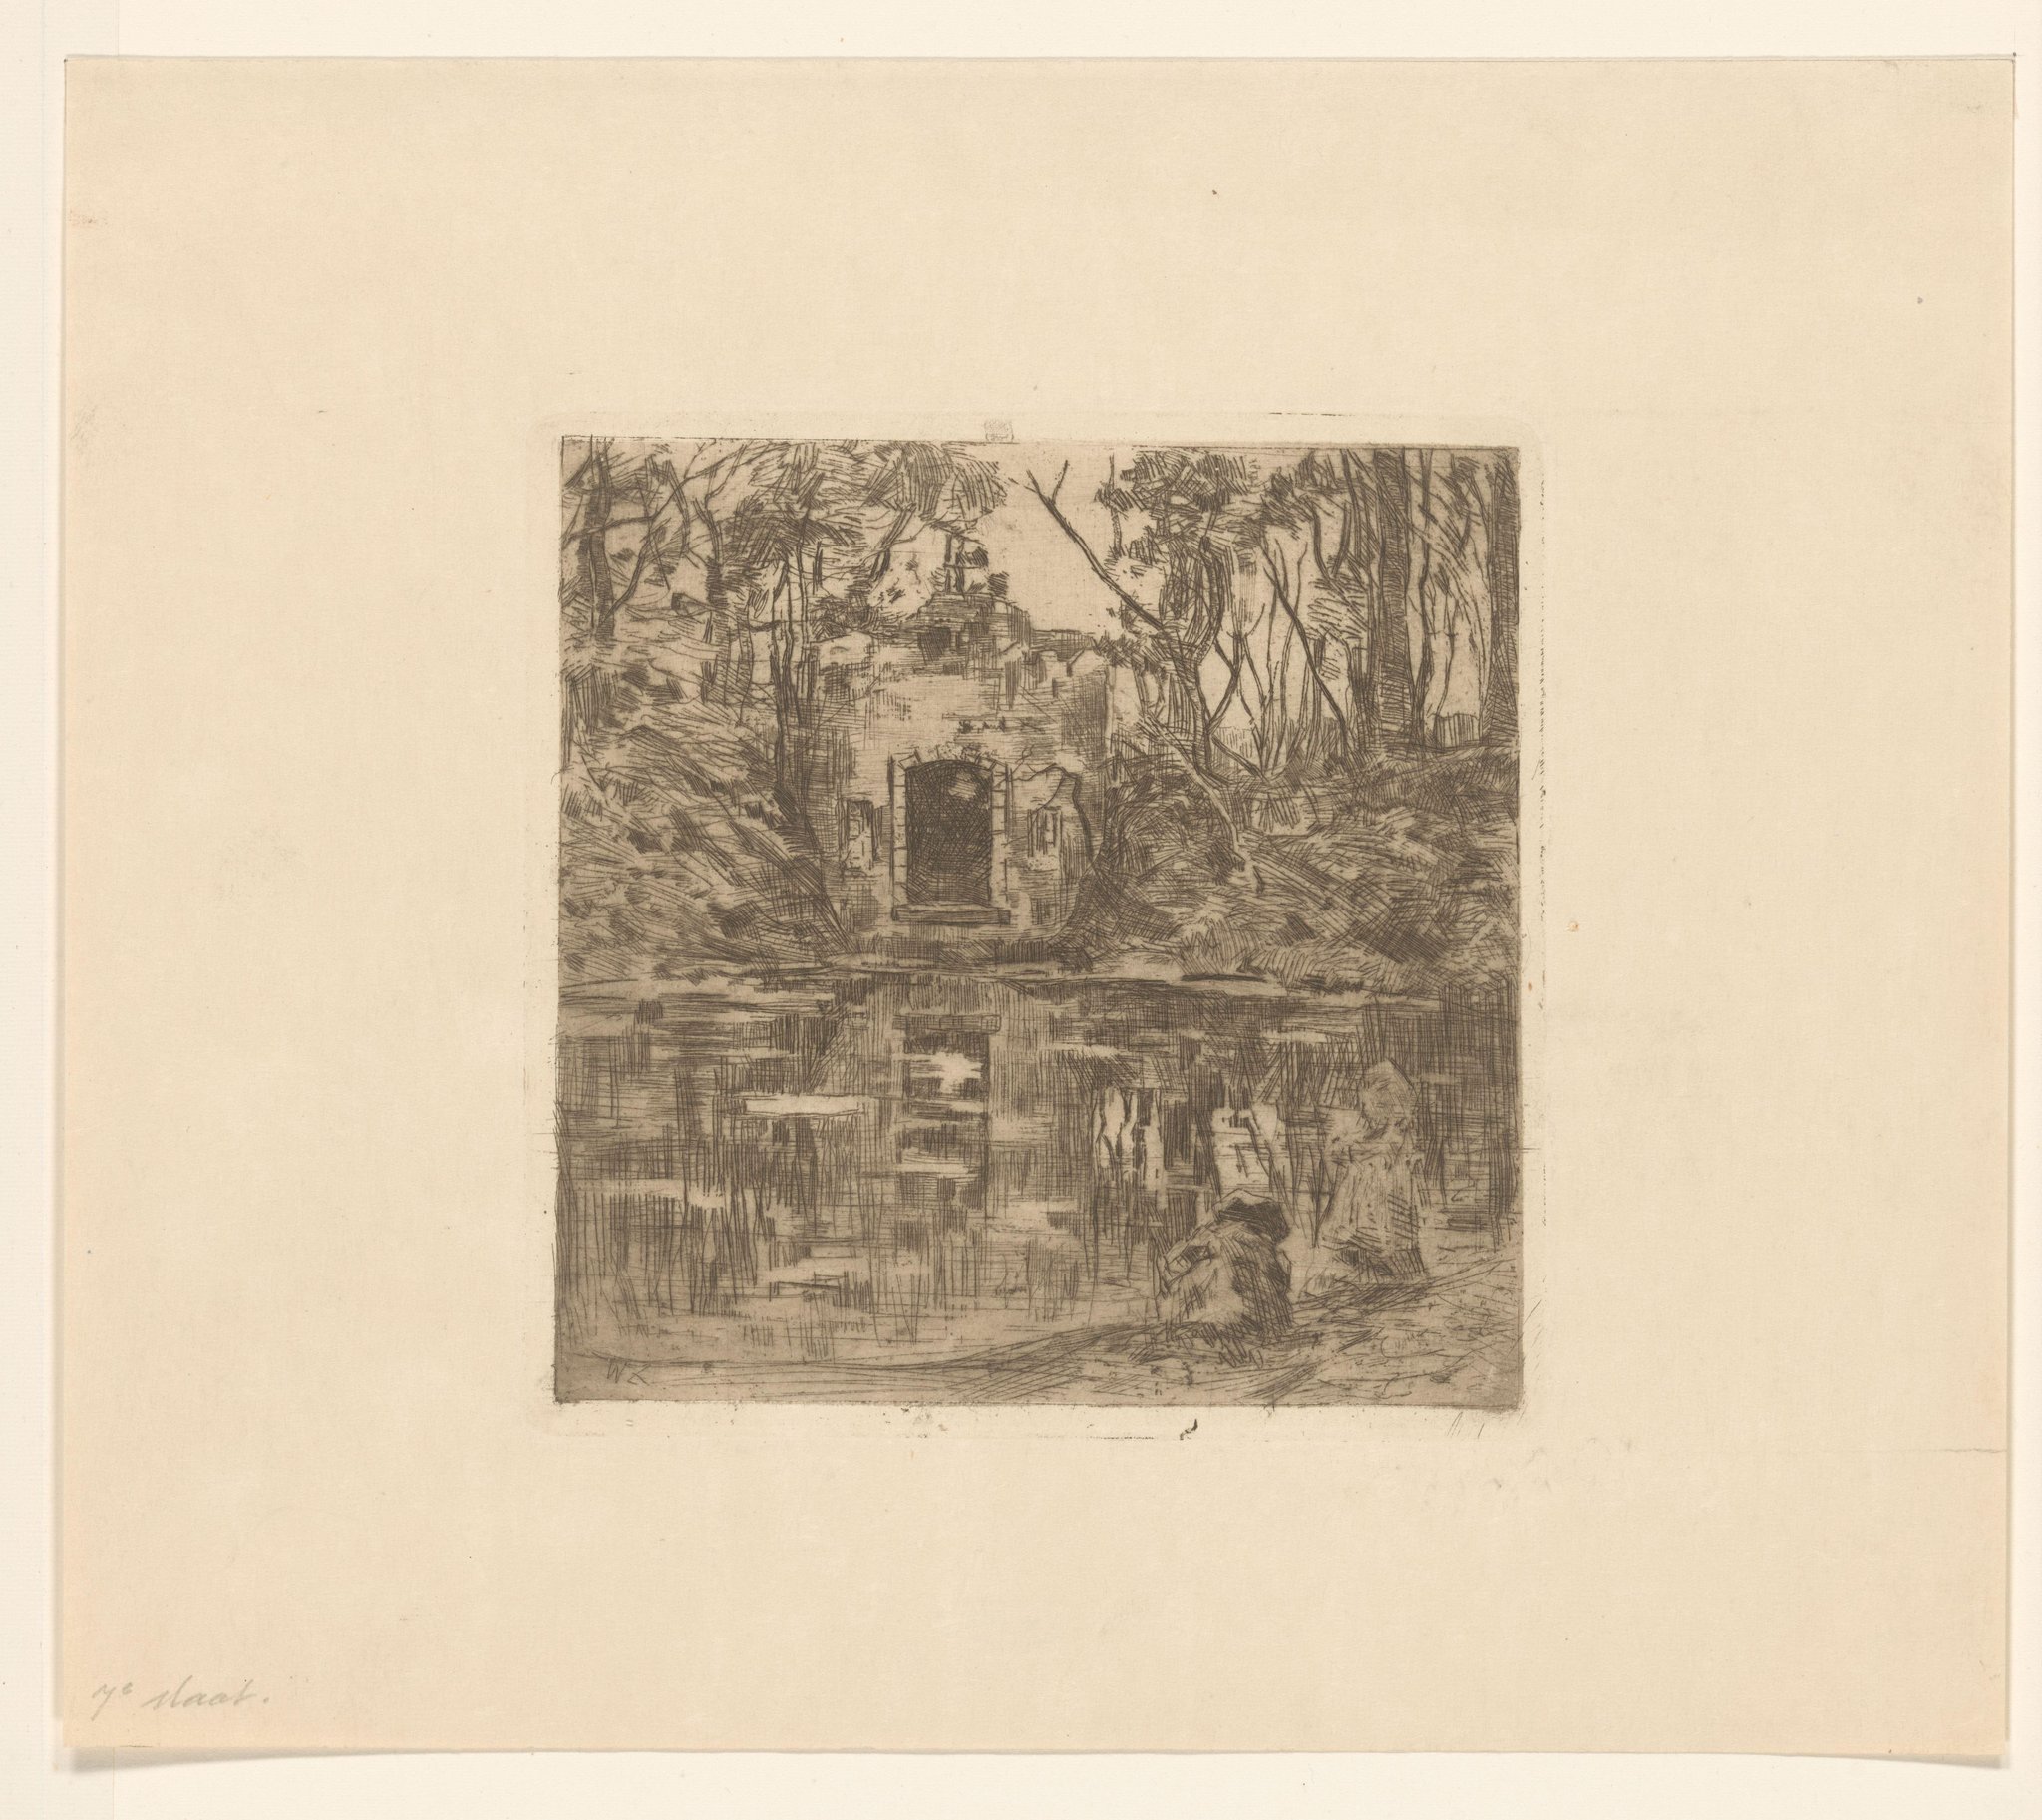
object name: print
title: Ruïne aan een vijver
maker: willem de zwart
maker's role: draughtsman, painter, print maker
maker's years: 1862-1931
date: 1896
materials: paper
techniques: drypoint, etching, intaglio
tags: landscape with ruins, pond, pool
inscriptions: collector's mark: Lugt 2228